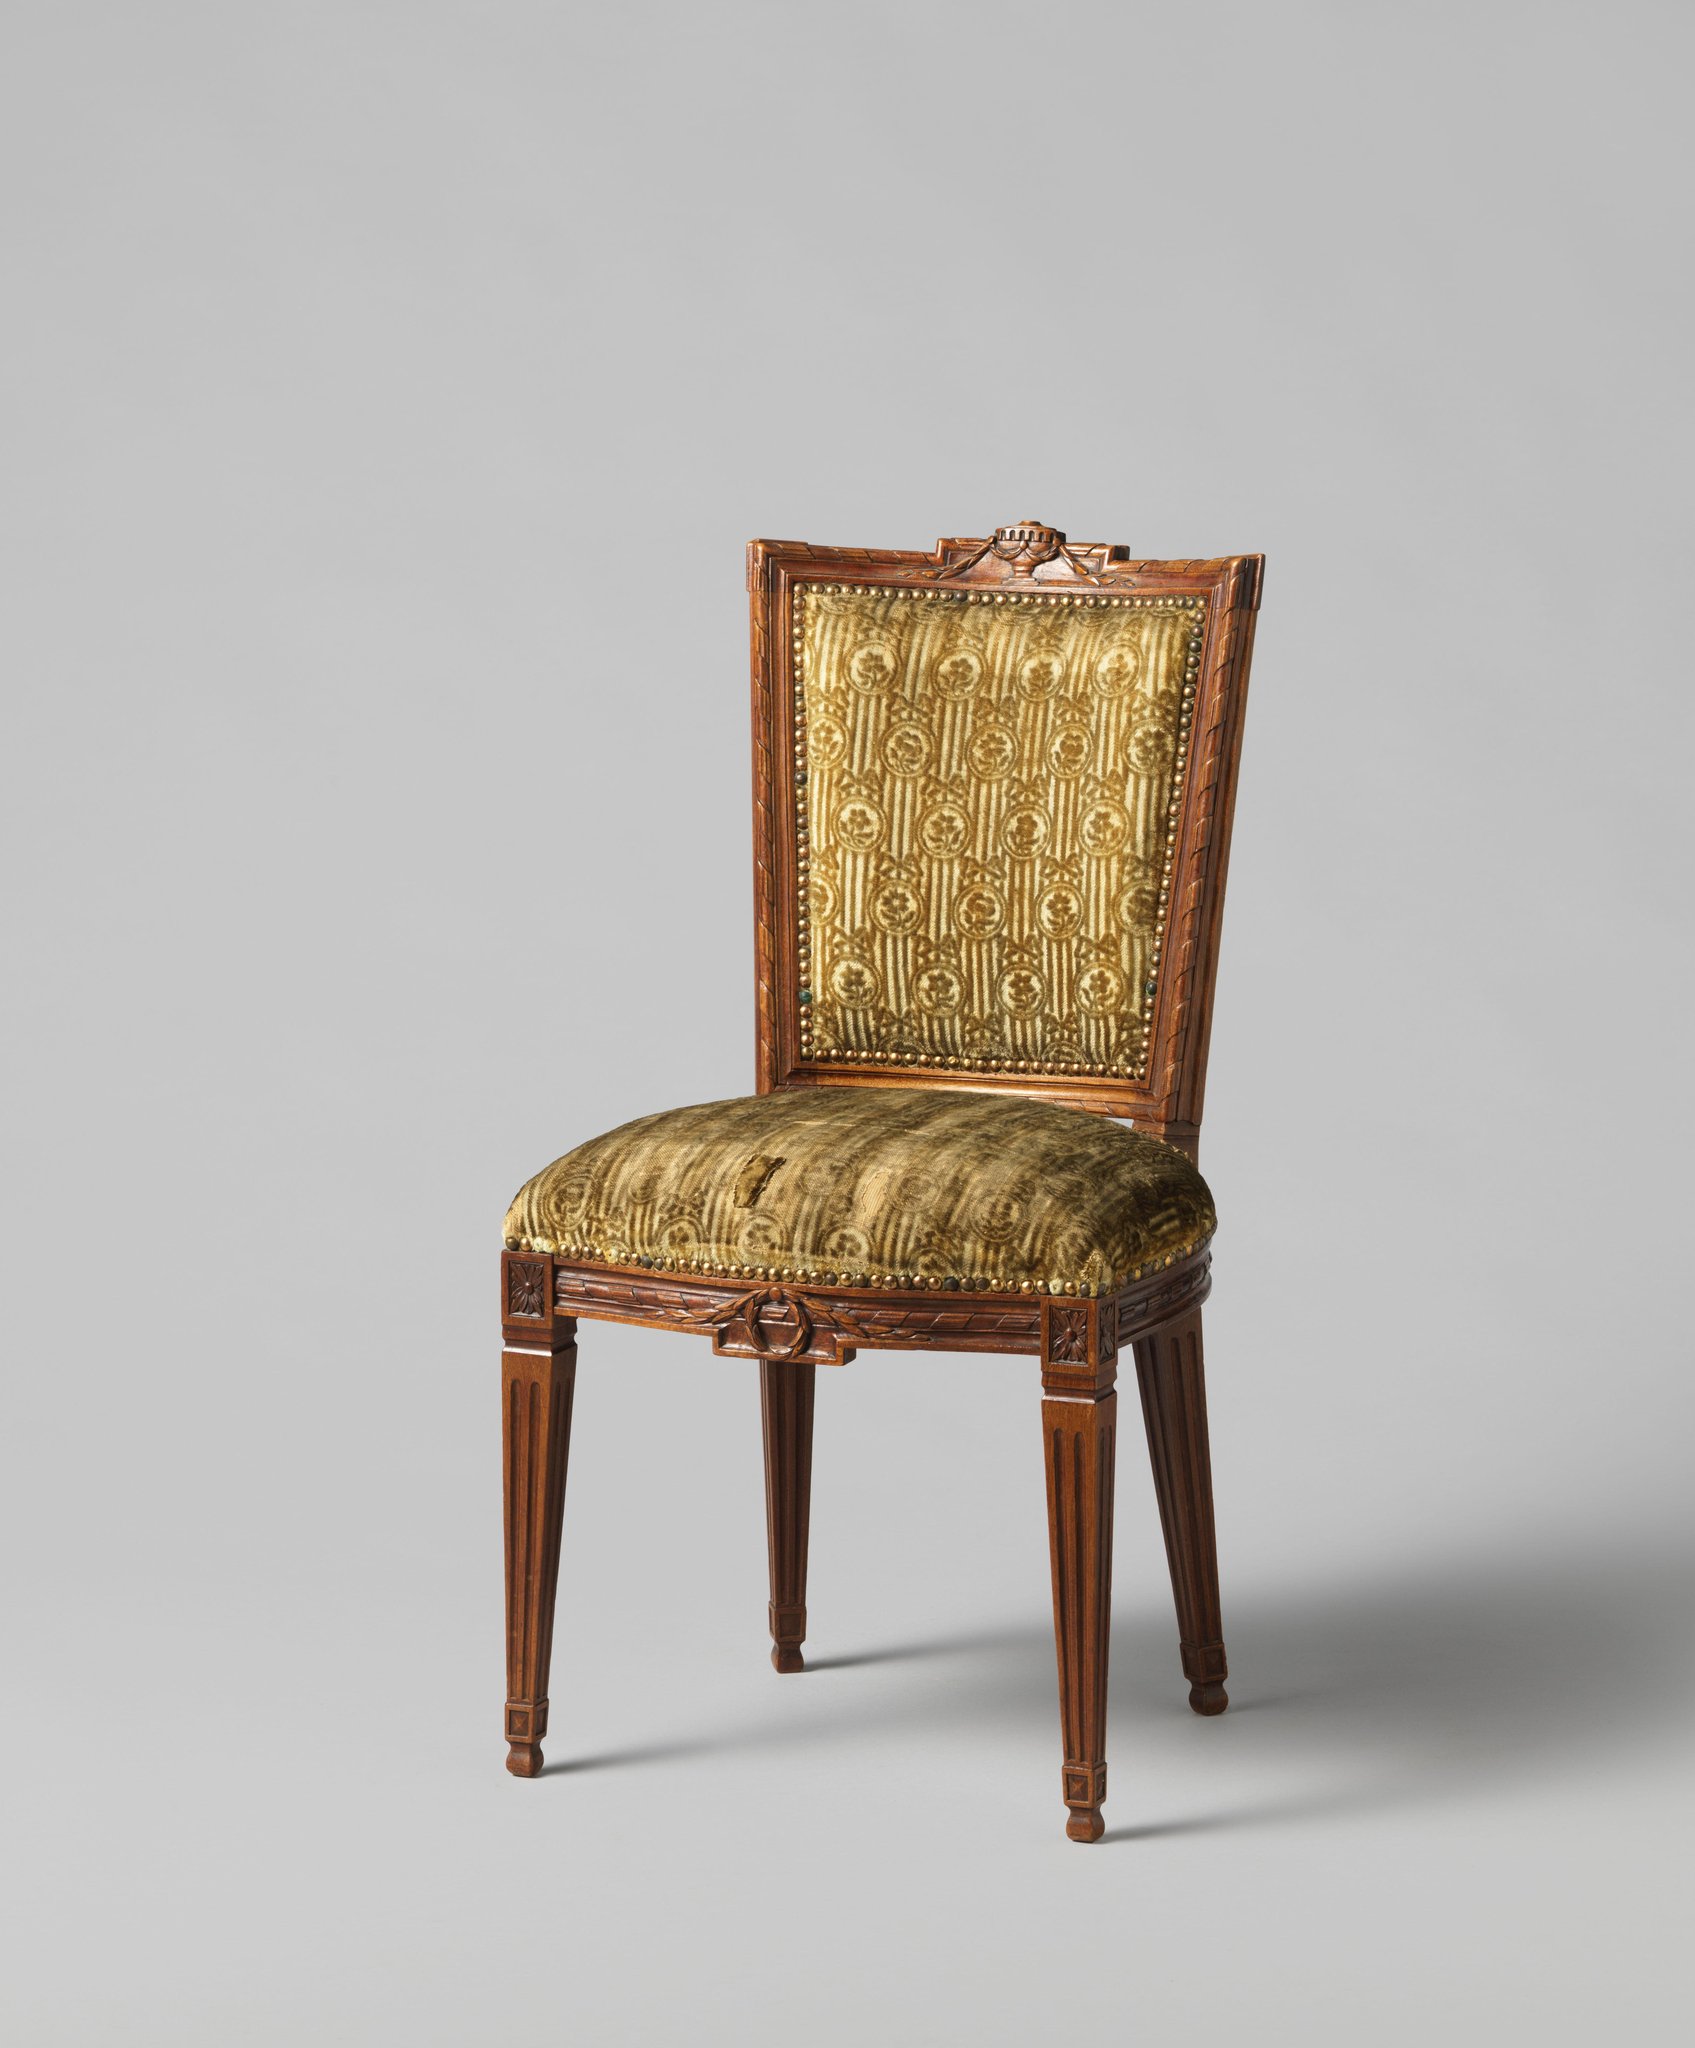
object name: furniture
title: Stoel van mahoniehout, bekleed met trijp met een doorlopend patroon van aan strikken hangende ovalen waarin bloem op streeppatroon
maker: Anonymous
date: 1775-1800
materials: wood, textile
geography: northern netherlands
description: Chair. Mahogany, with the original upholstery of moquette (trijp). Netherlands, c. 1780 - 1800. Mr and Mrs Drucker-Fraser bequest, 1949.